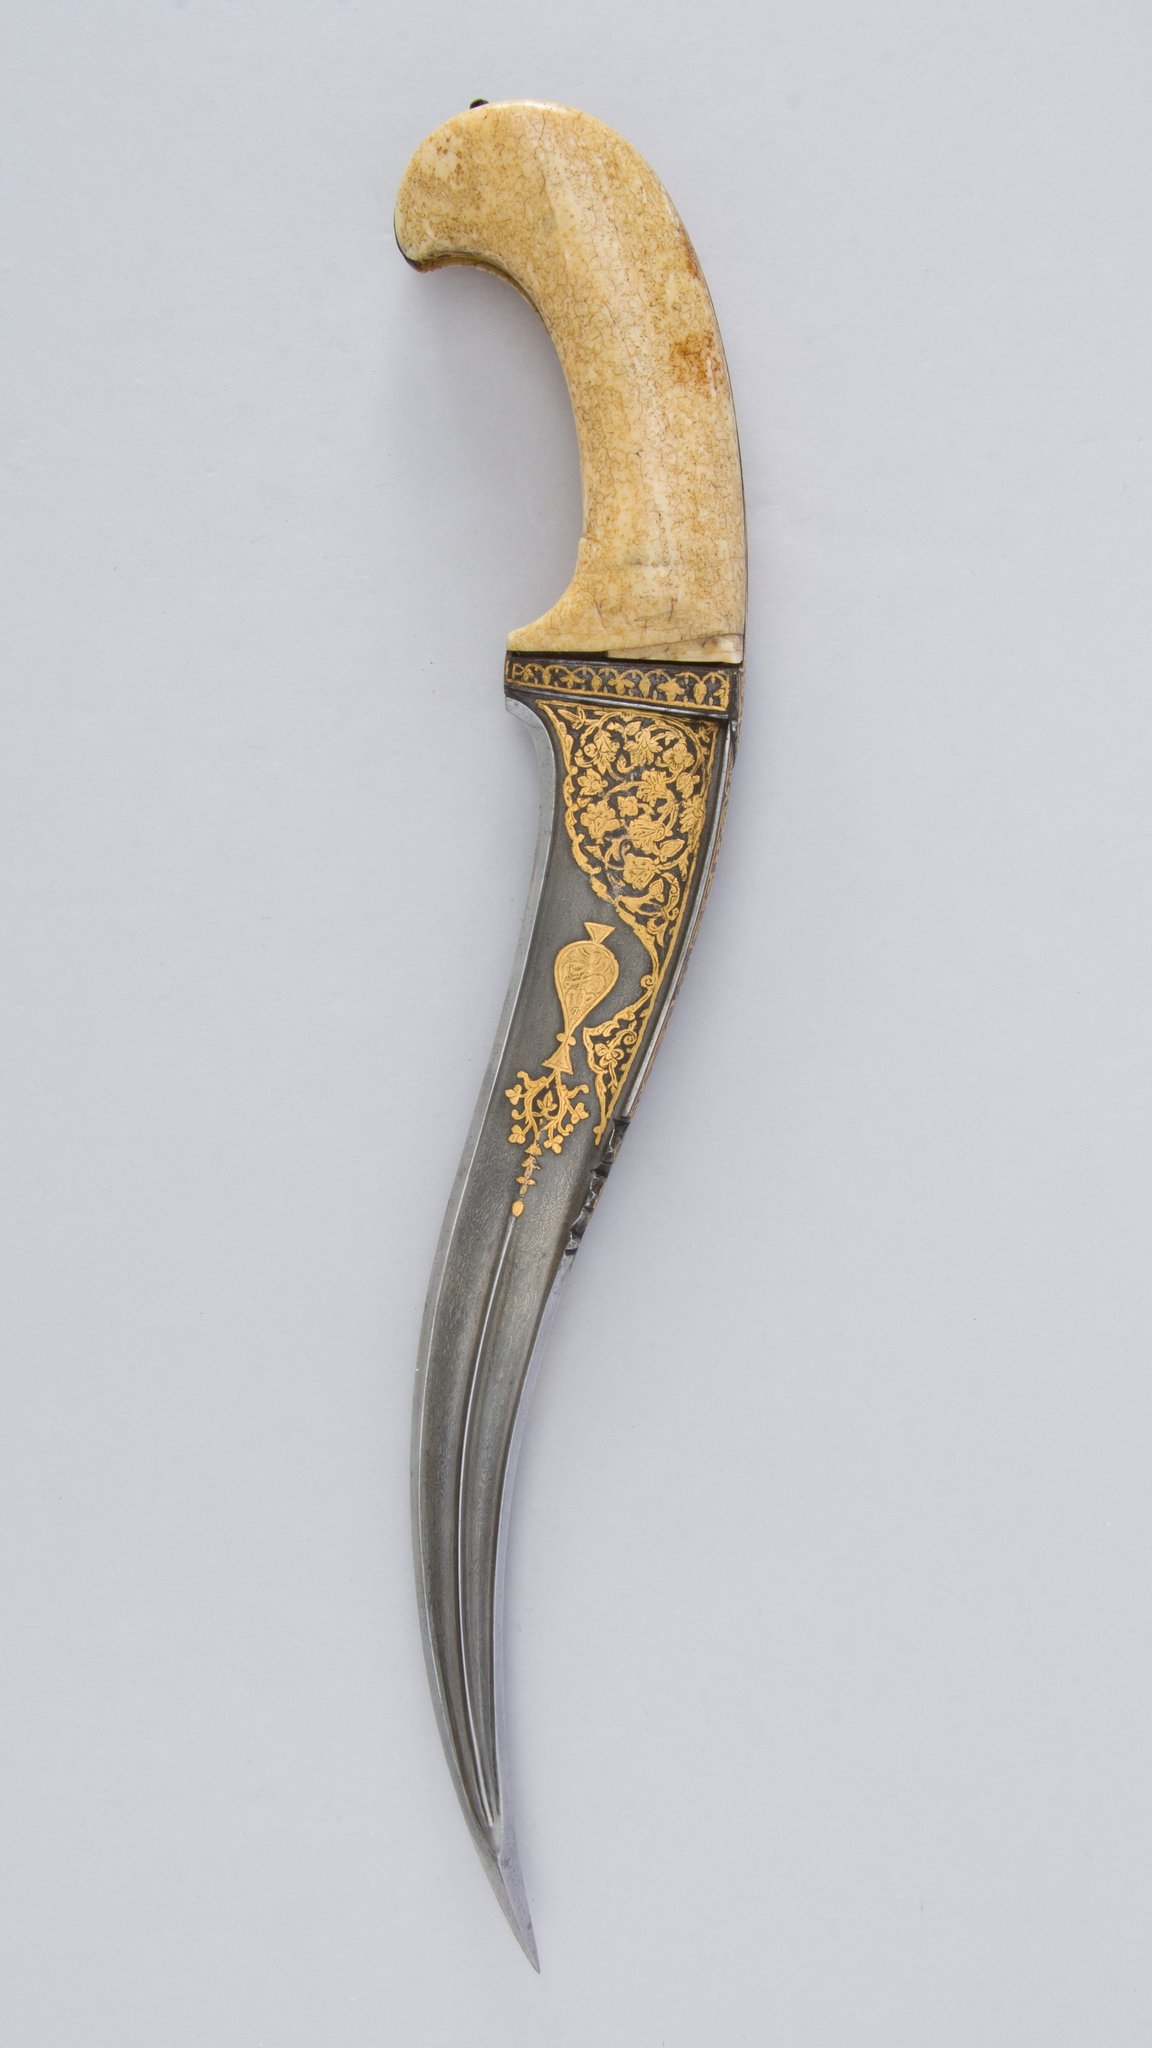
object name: dagger pesh kabz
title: Dagger (Pesh-kabz)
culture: iranian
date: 1801-1900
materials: gold, ivory, steel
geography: iran